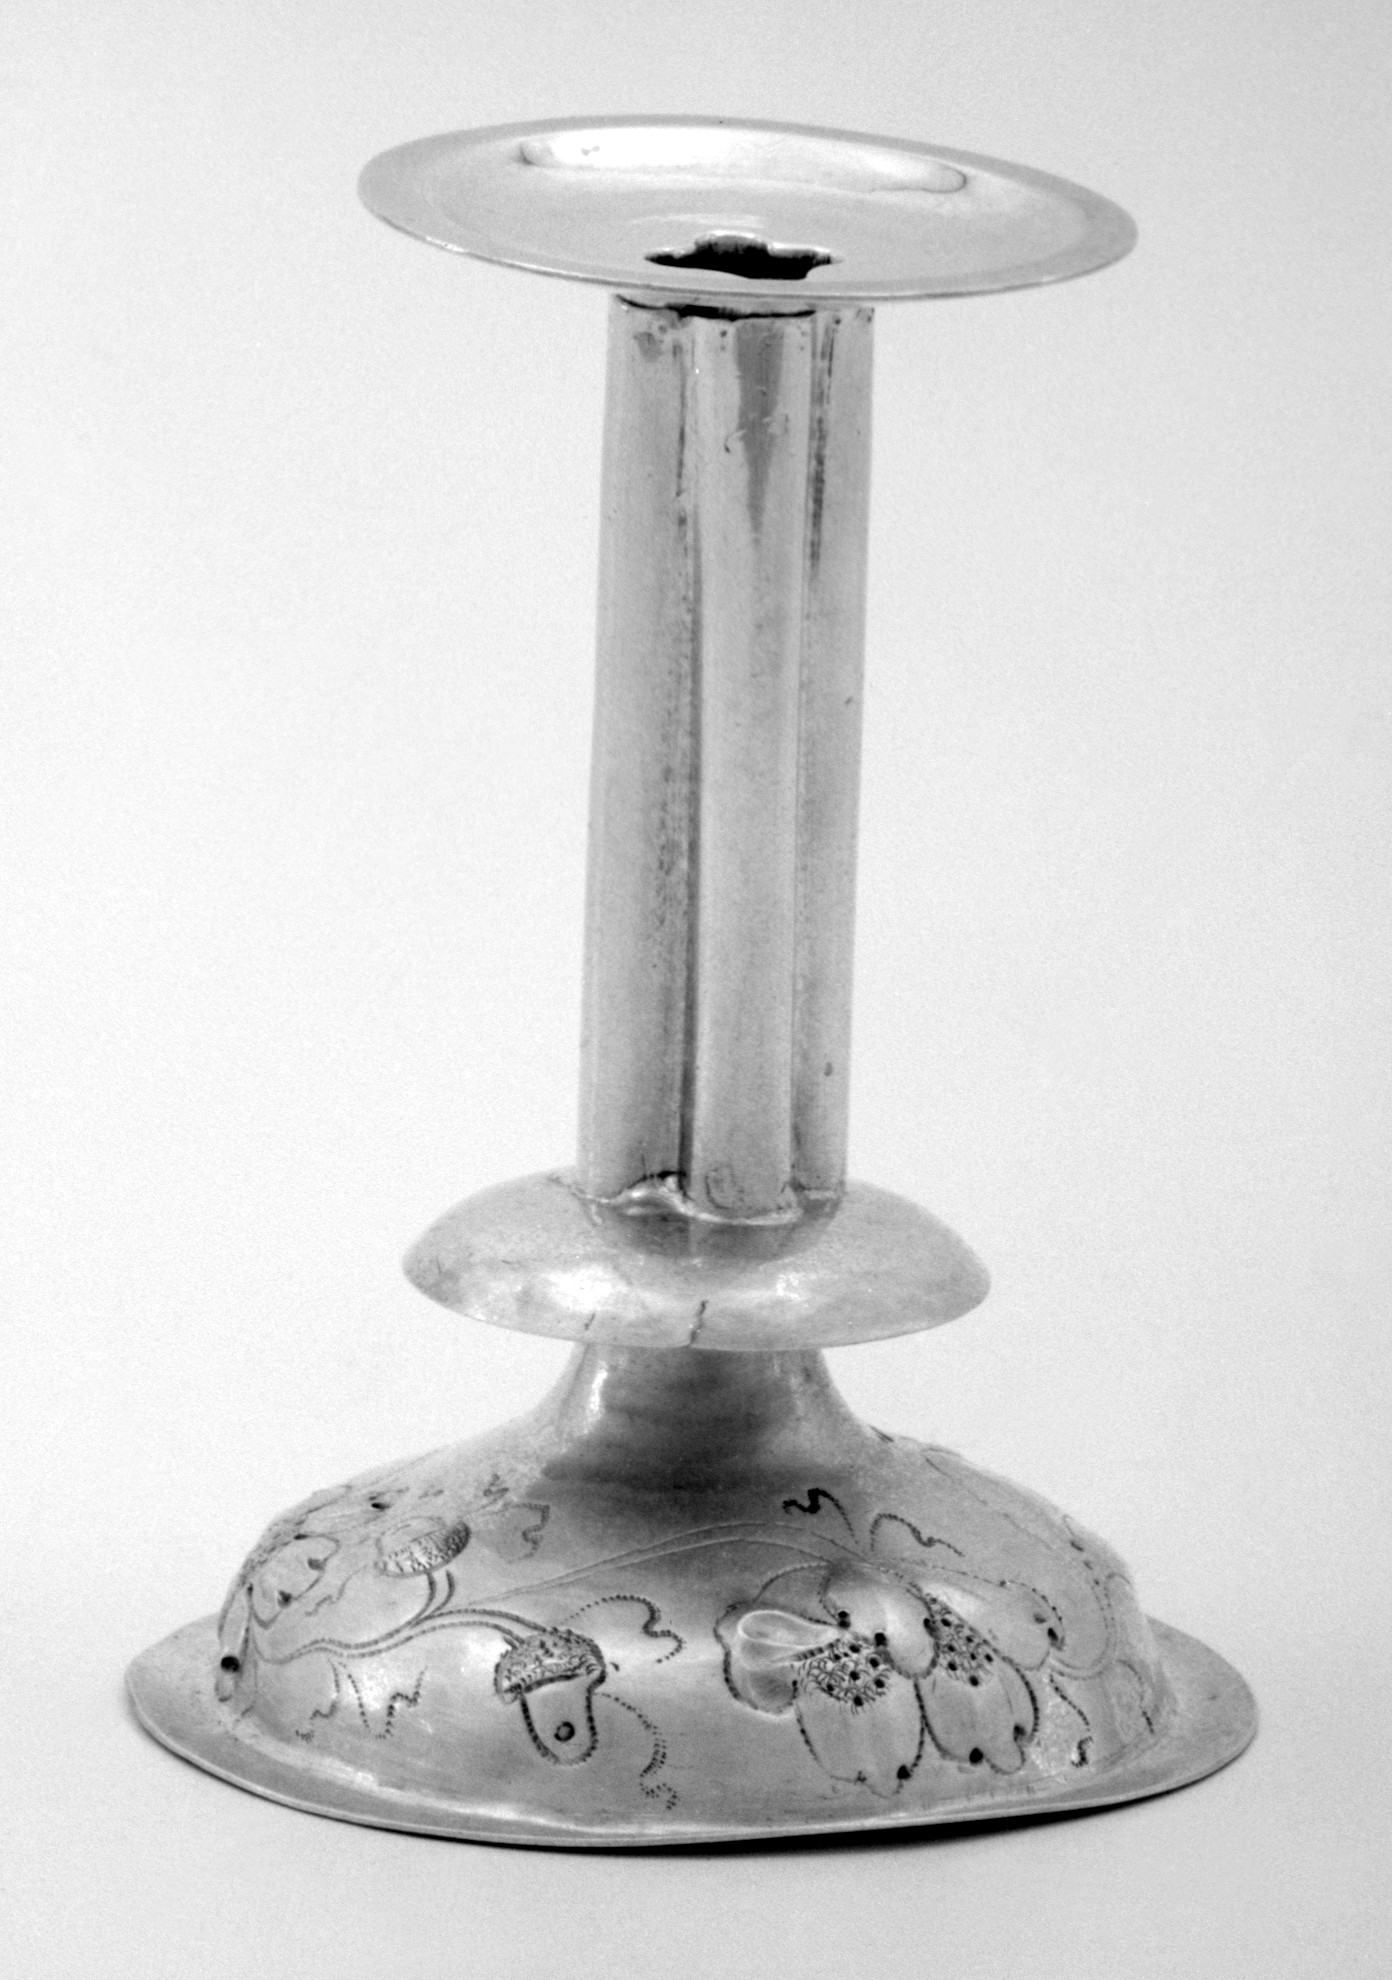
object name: taperstick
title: Pair of miniature tapersticks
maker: a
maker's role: maker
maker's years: 1650-1750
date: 1700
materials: silver